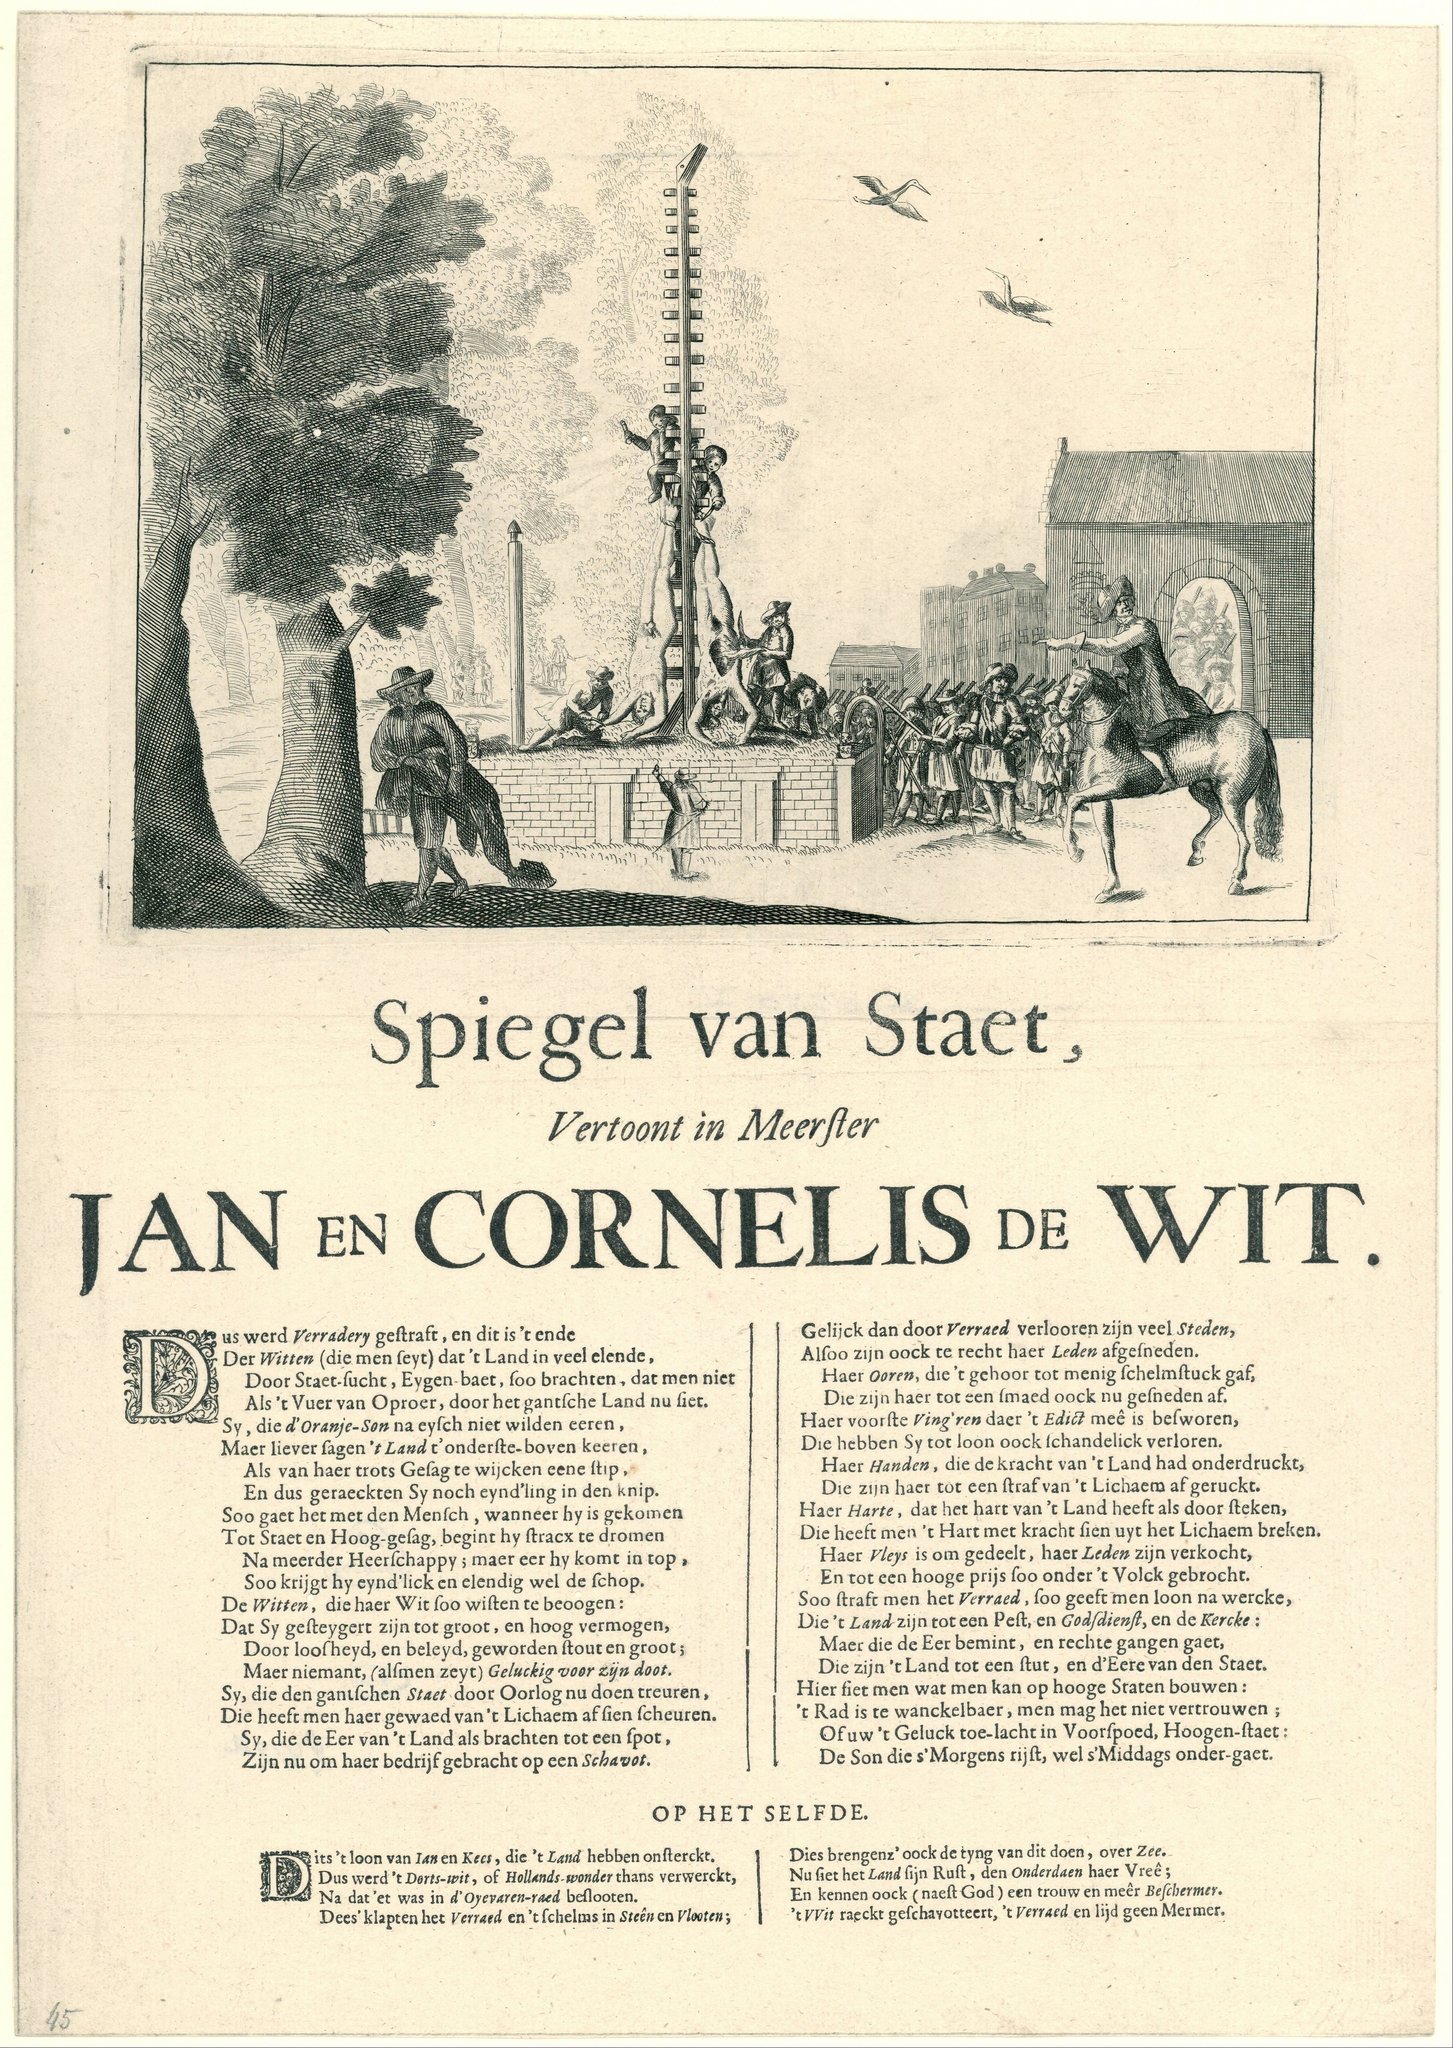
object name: print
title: Verminking van de lichamen van de gebroeders de Witt, 1672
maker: Anonymous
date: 1672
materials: paper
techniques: engraving, etching, letterpress printing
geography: northern netherlands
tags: cornelis de witt, rotterdam, amsterdam, cornelis tromp, the hague, politician, johan de witt, mutilation of the corpse, lynching, attempt, political murder, violent death, being killed; being mishandled and maltreated; seeking death (+ death by lynching)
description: Eenvoudige voorstelling van de verminking van de lichamen van de gebroeders Johan en Cornelis de Witt, 20 augustus 1672. Rechts een ruiter; op de voorgrond een man met een kledingstuk van een van de slachtoffers. Deze staat van de prent is mét de figuren in de poort achter de ruiter, de man voor het schavot en de twee jongens op de wip. Volgens de beschrijving van deze prent door Knuttel, zou de man staande voor het schavot Cornelis Tromp voorstellen. Onder de voorstelling twee verzen waarin de moorden worden gerechtvaardigd.